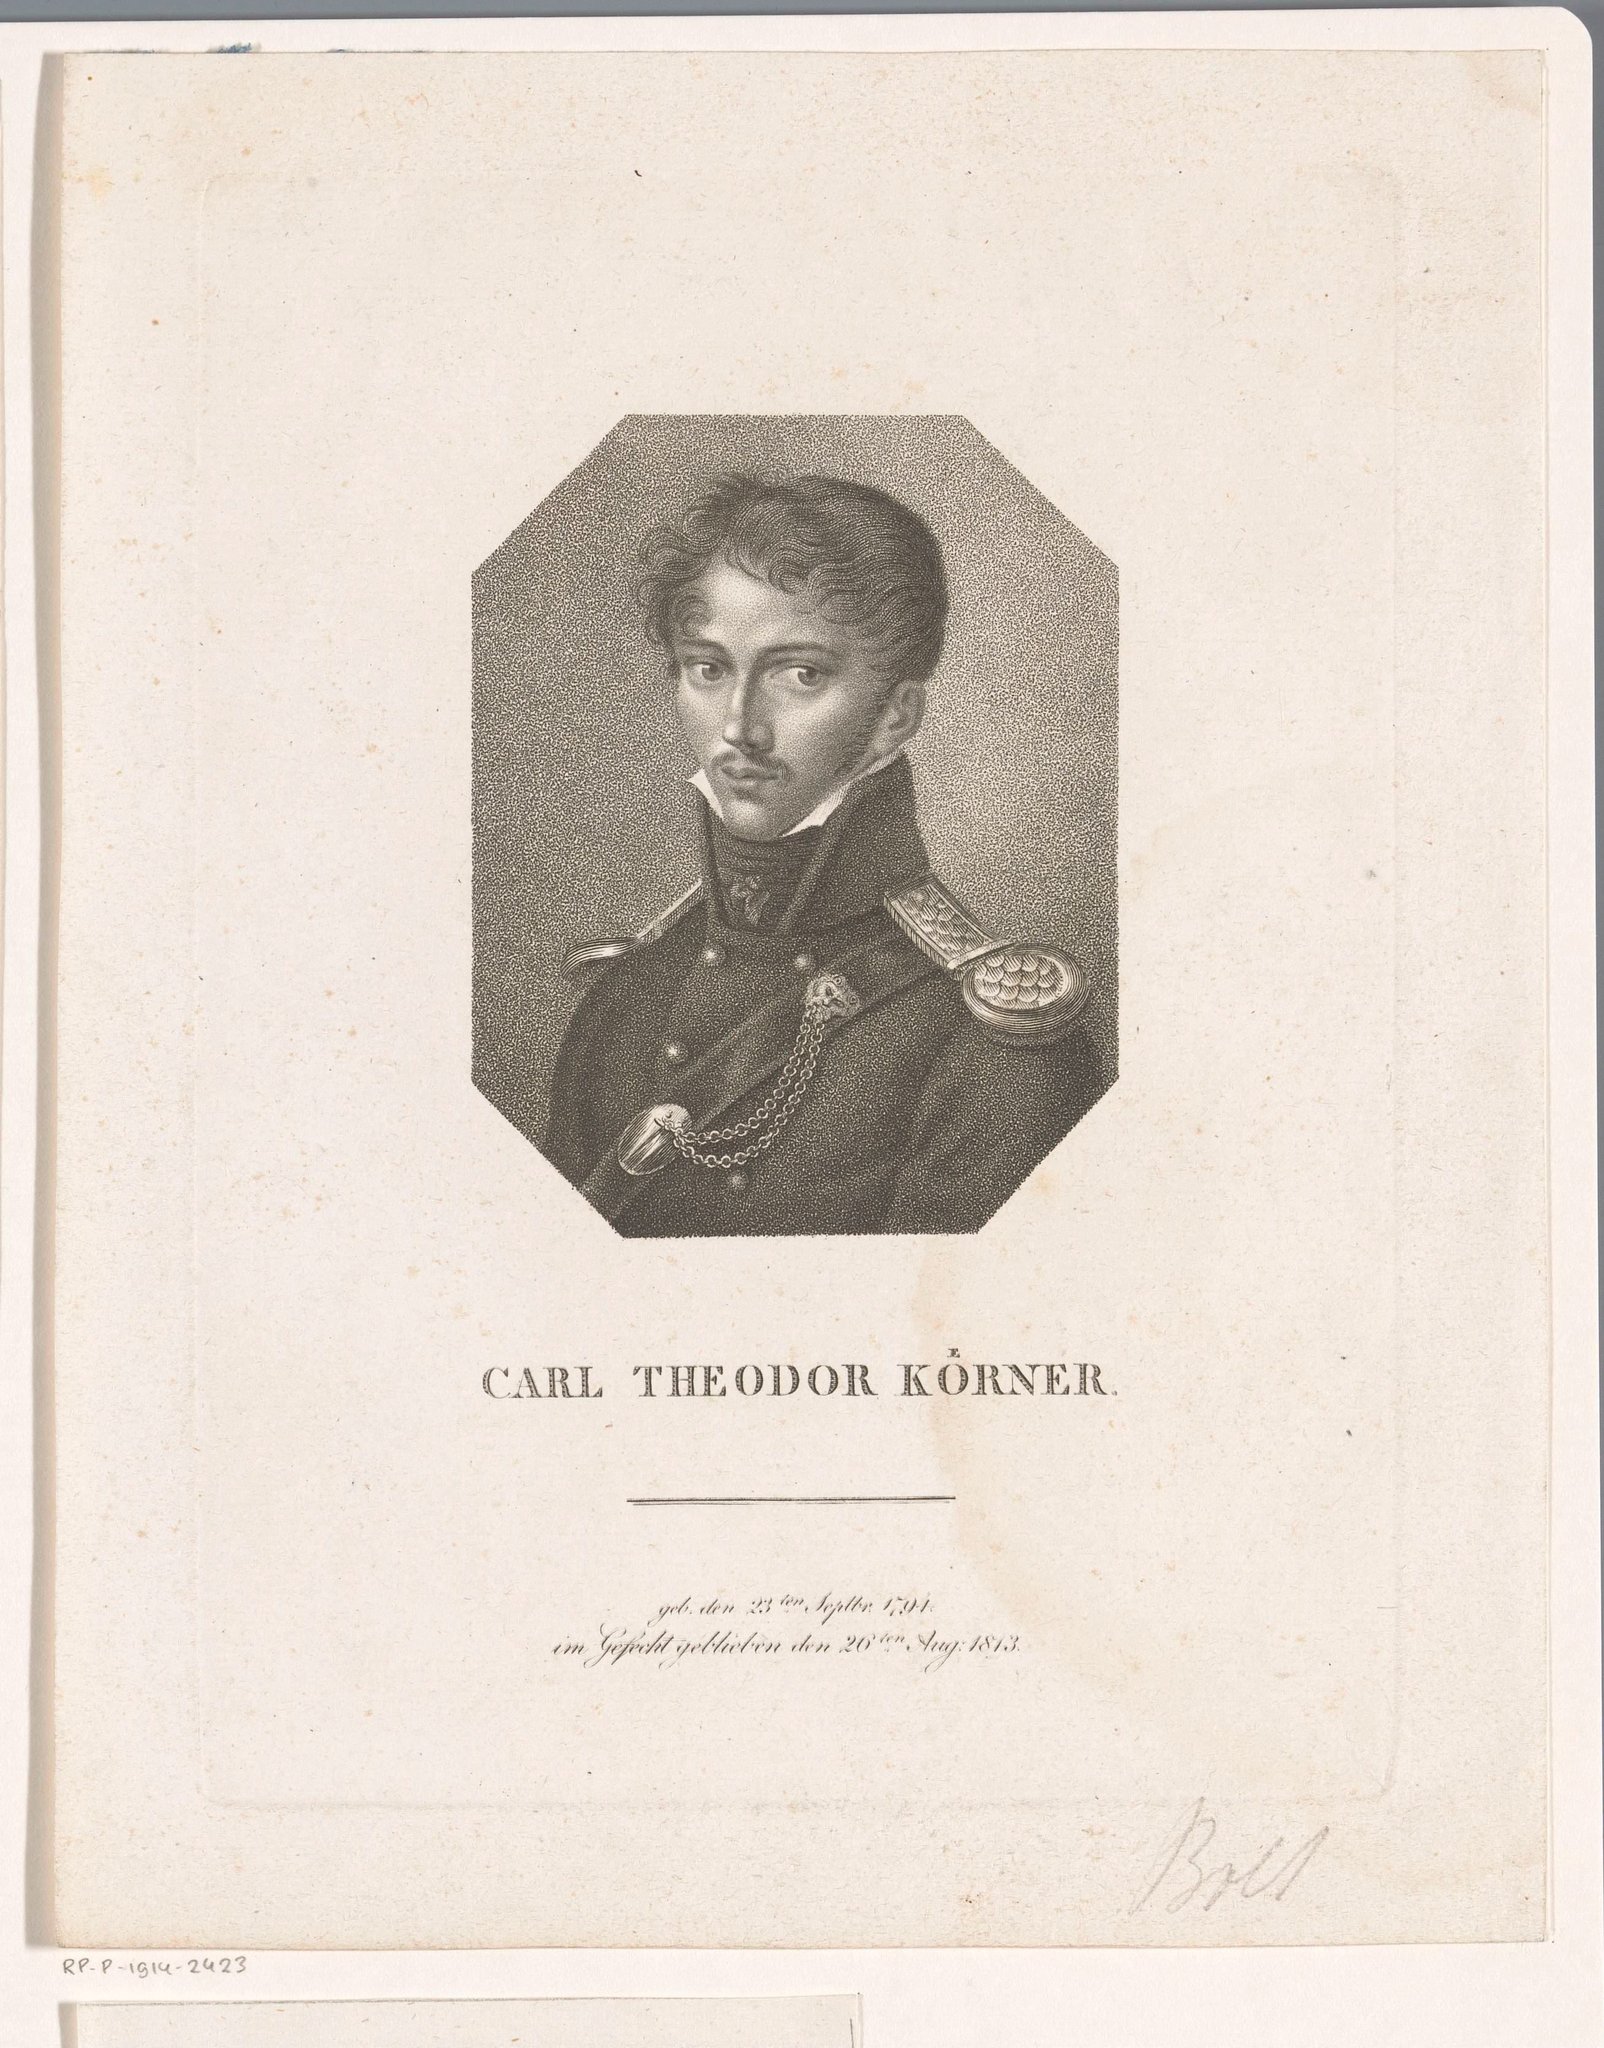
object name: print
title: Portret van Theodor Körner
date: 1813-1836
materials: paper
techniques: stippling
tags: historical persons, (military) uniforms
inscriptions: collector's mark: Lugt 2228